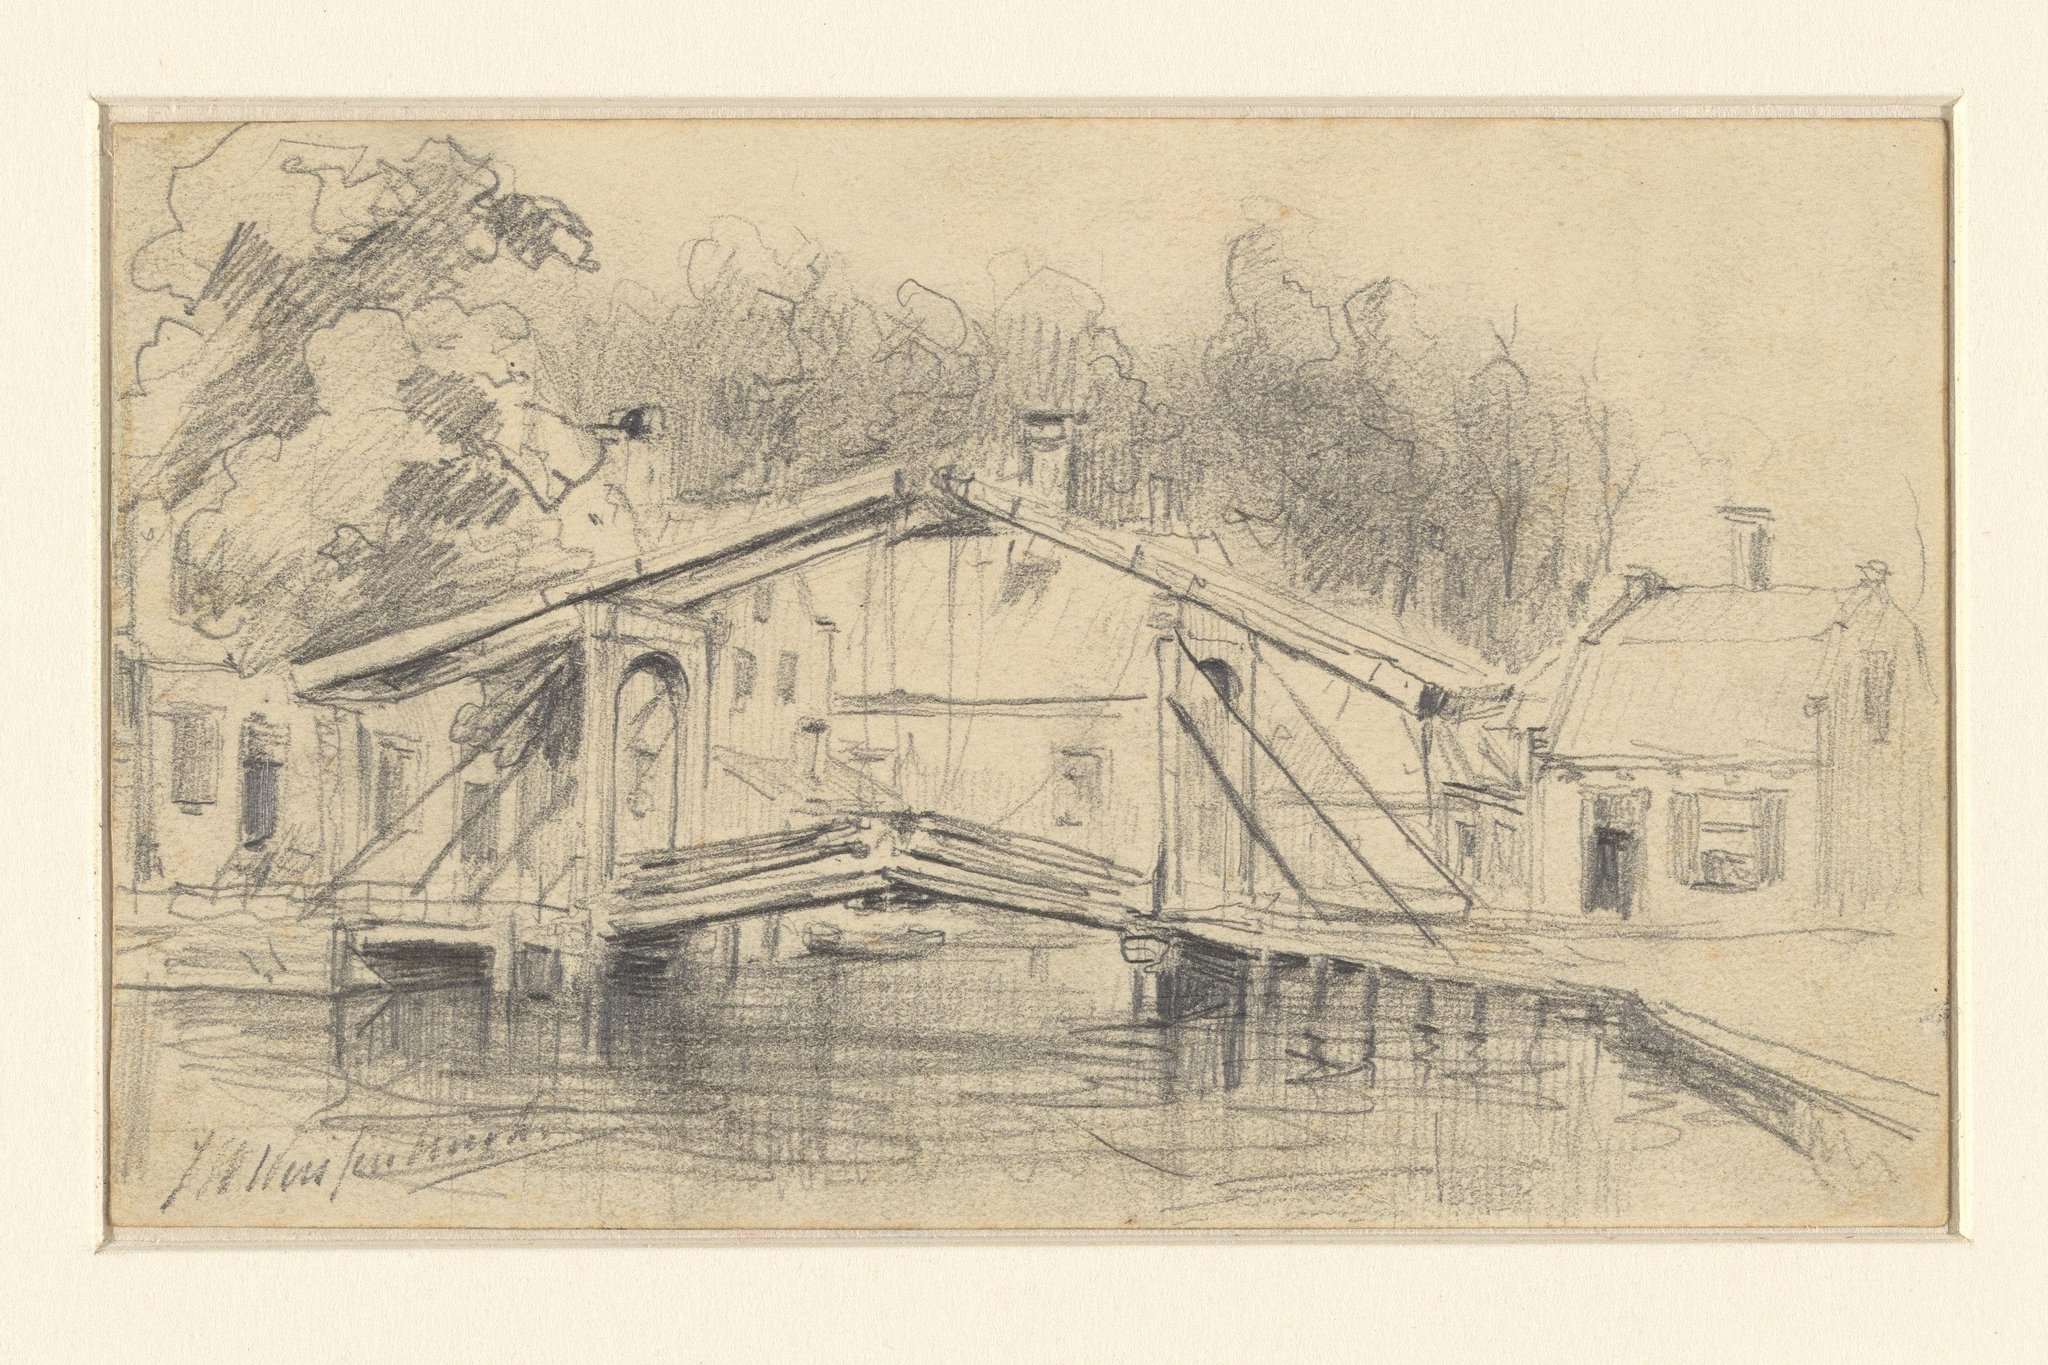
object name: drawing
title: Ophaalbruggetje in een dorp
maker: johan hendrik weissenbruch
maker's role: draughtsman, painter, print maker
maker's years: 1824-1903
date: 1834-1903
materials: paper, pencil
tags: village, bridge in village across river, canal, etc.